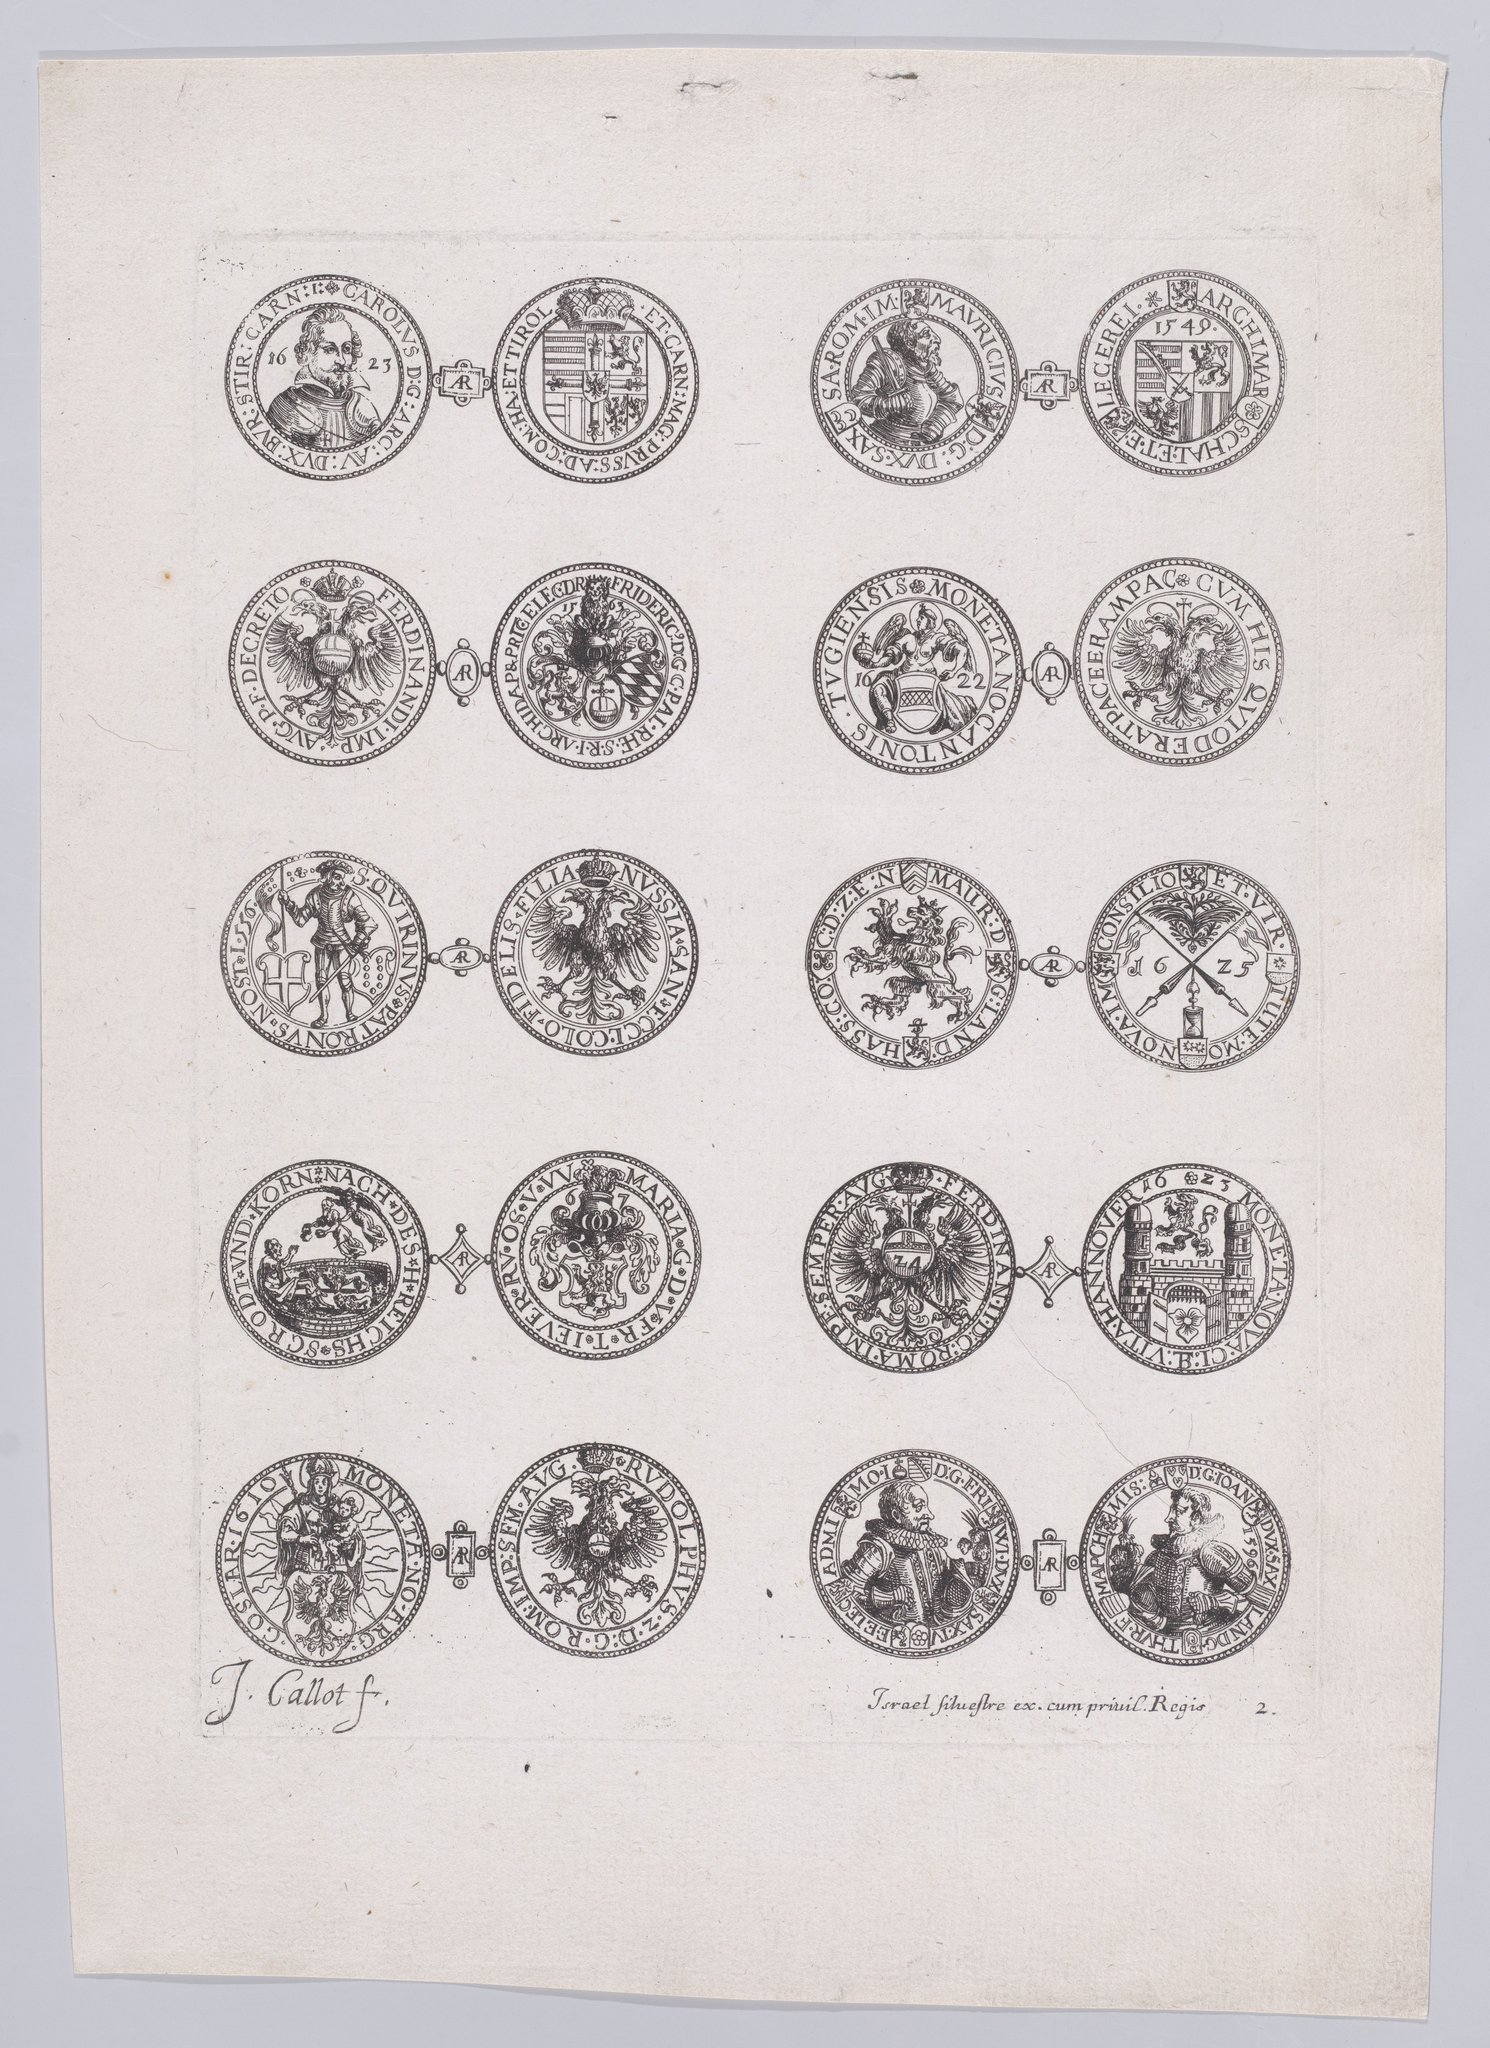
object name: print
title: 2nd Plate, Featuring 10 Coins Issued by European Princes in the 16th and 17th centuries, from Les Monnaies (The Currencies)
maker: jacques callot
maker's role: artist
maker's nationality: french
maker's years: 1592-1635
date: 1630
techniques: etching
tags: coins